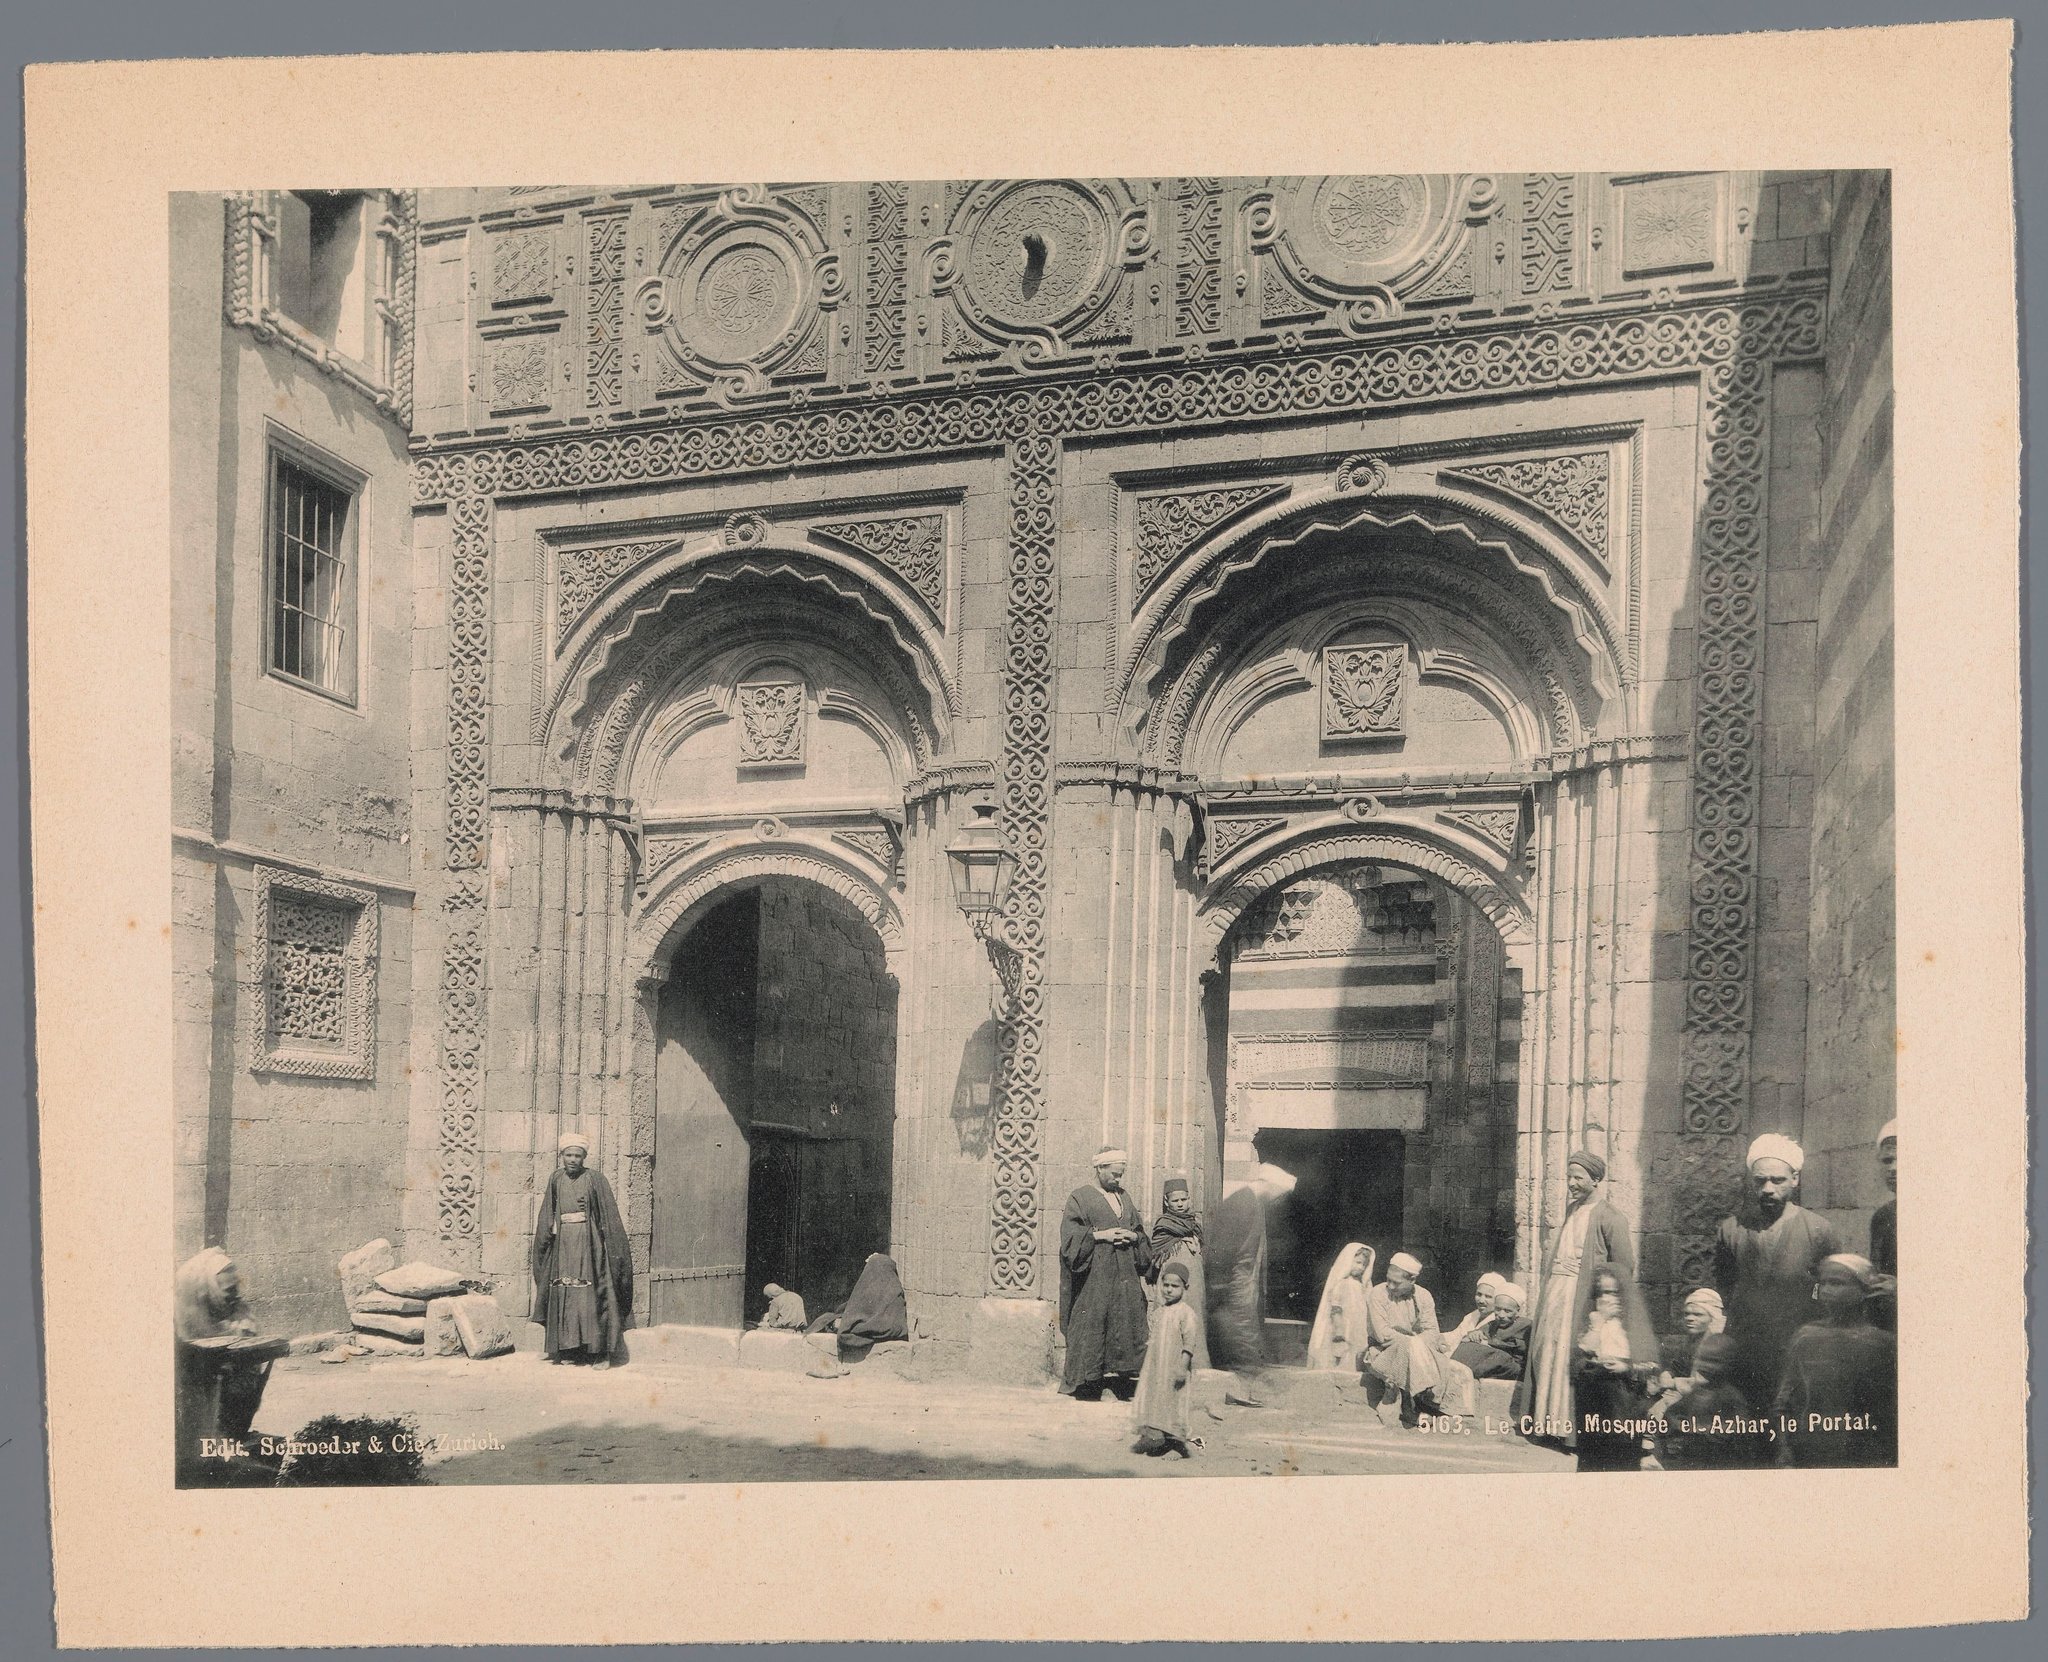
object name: photograph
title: Portaal van de Al-Azhar-moskee te Caïro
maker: Anonymous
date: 1875-1900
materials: cardboard, paper, ink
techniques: photograph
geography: zurich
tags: parts of church exterior and annexes: porch, flat decoration ~ applied arts (+ islamic art), temple, shrine ~ islam, mohammedanism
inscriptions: collector's mark: ‘KUNSTNIJVERHEIDSCHOOL QUELLINUS AMSTERDAM FRANS HALSSTRAAT 14.’, collector's mark: ‘INSTITUUT VOOR KUNST-NIJVERHEIDSONDERWIJS GABRIËL METSUSTRAAT No. 16 AMSTERDAM’, number: ‘5163.’